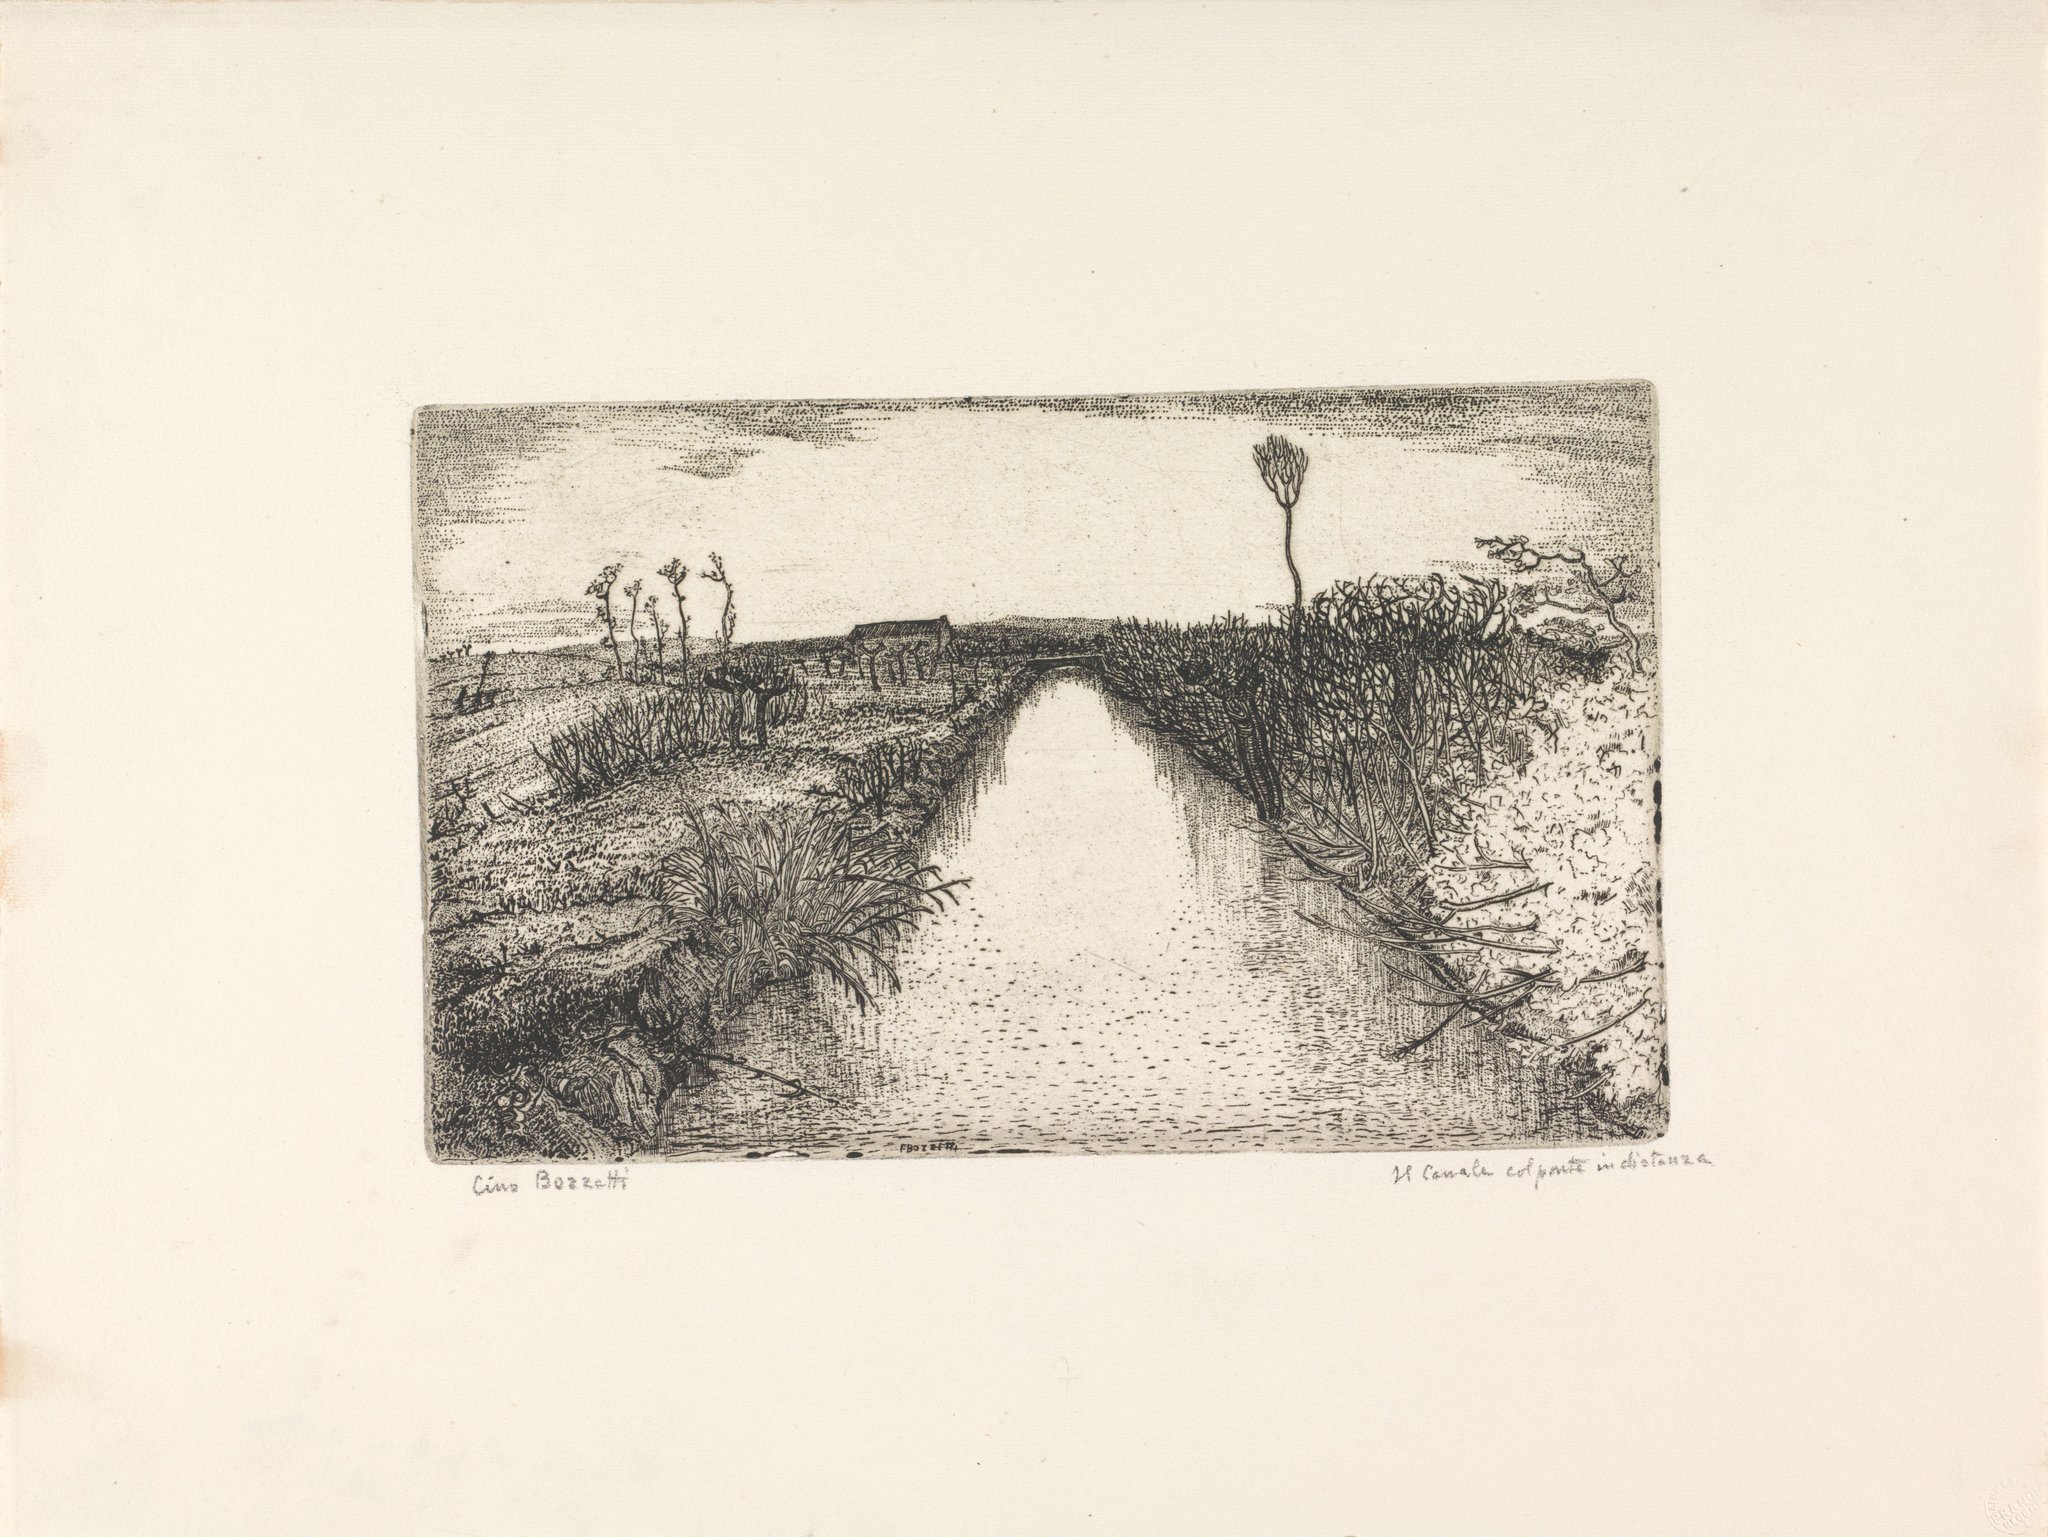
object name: print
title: Landschap met kanaal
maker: cino bozzetti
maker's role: print maker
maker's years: 1876-1949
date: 1886-1949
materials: paper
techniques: etching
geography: italy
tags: landscapes, canal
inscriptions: collector's mark: Lugt 2228, collector's mark: ‘Libreria Prand Reggio E.’, collector's mark: Lugt 2760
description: Landschap met een kanaal. In de verte een brug over het kanaal.